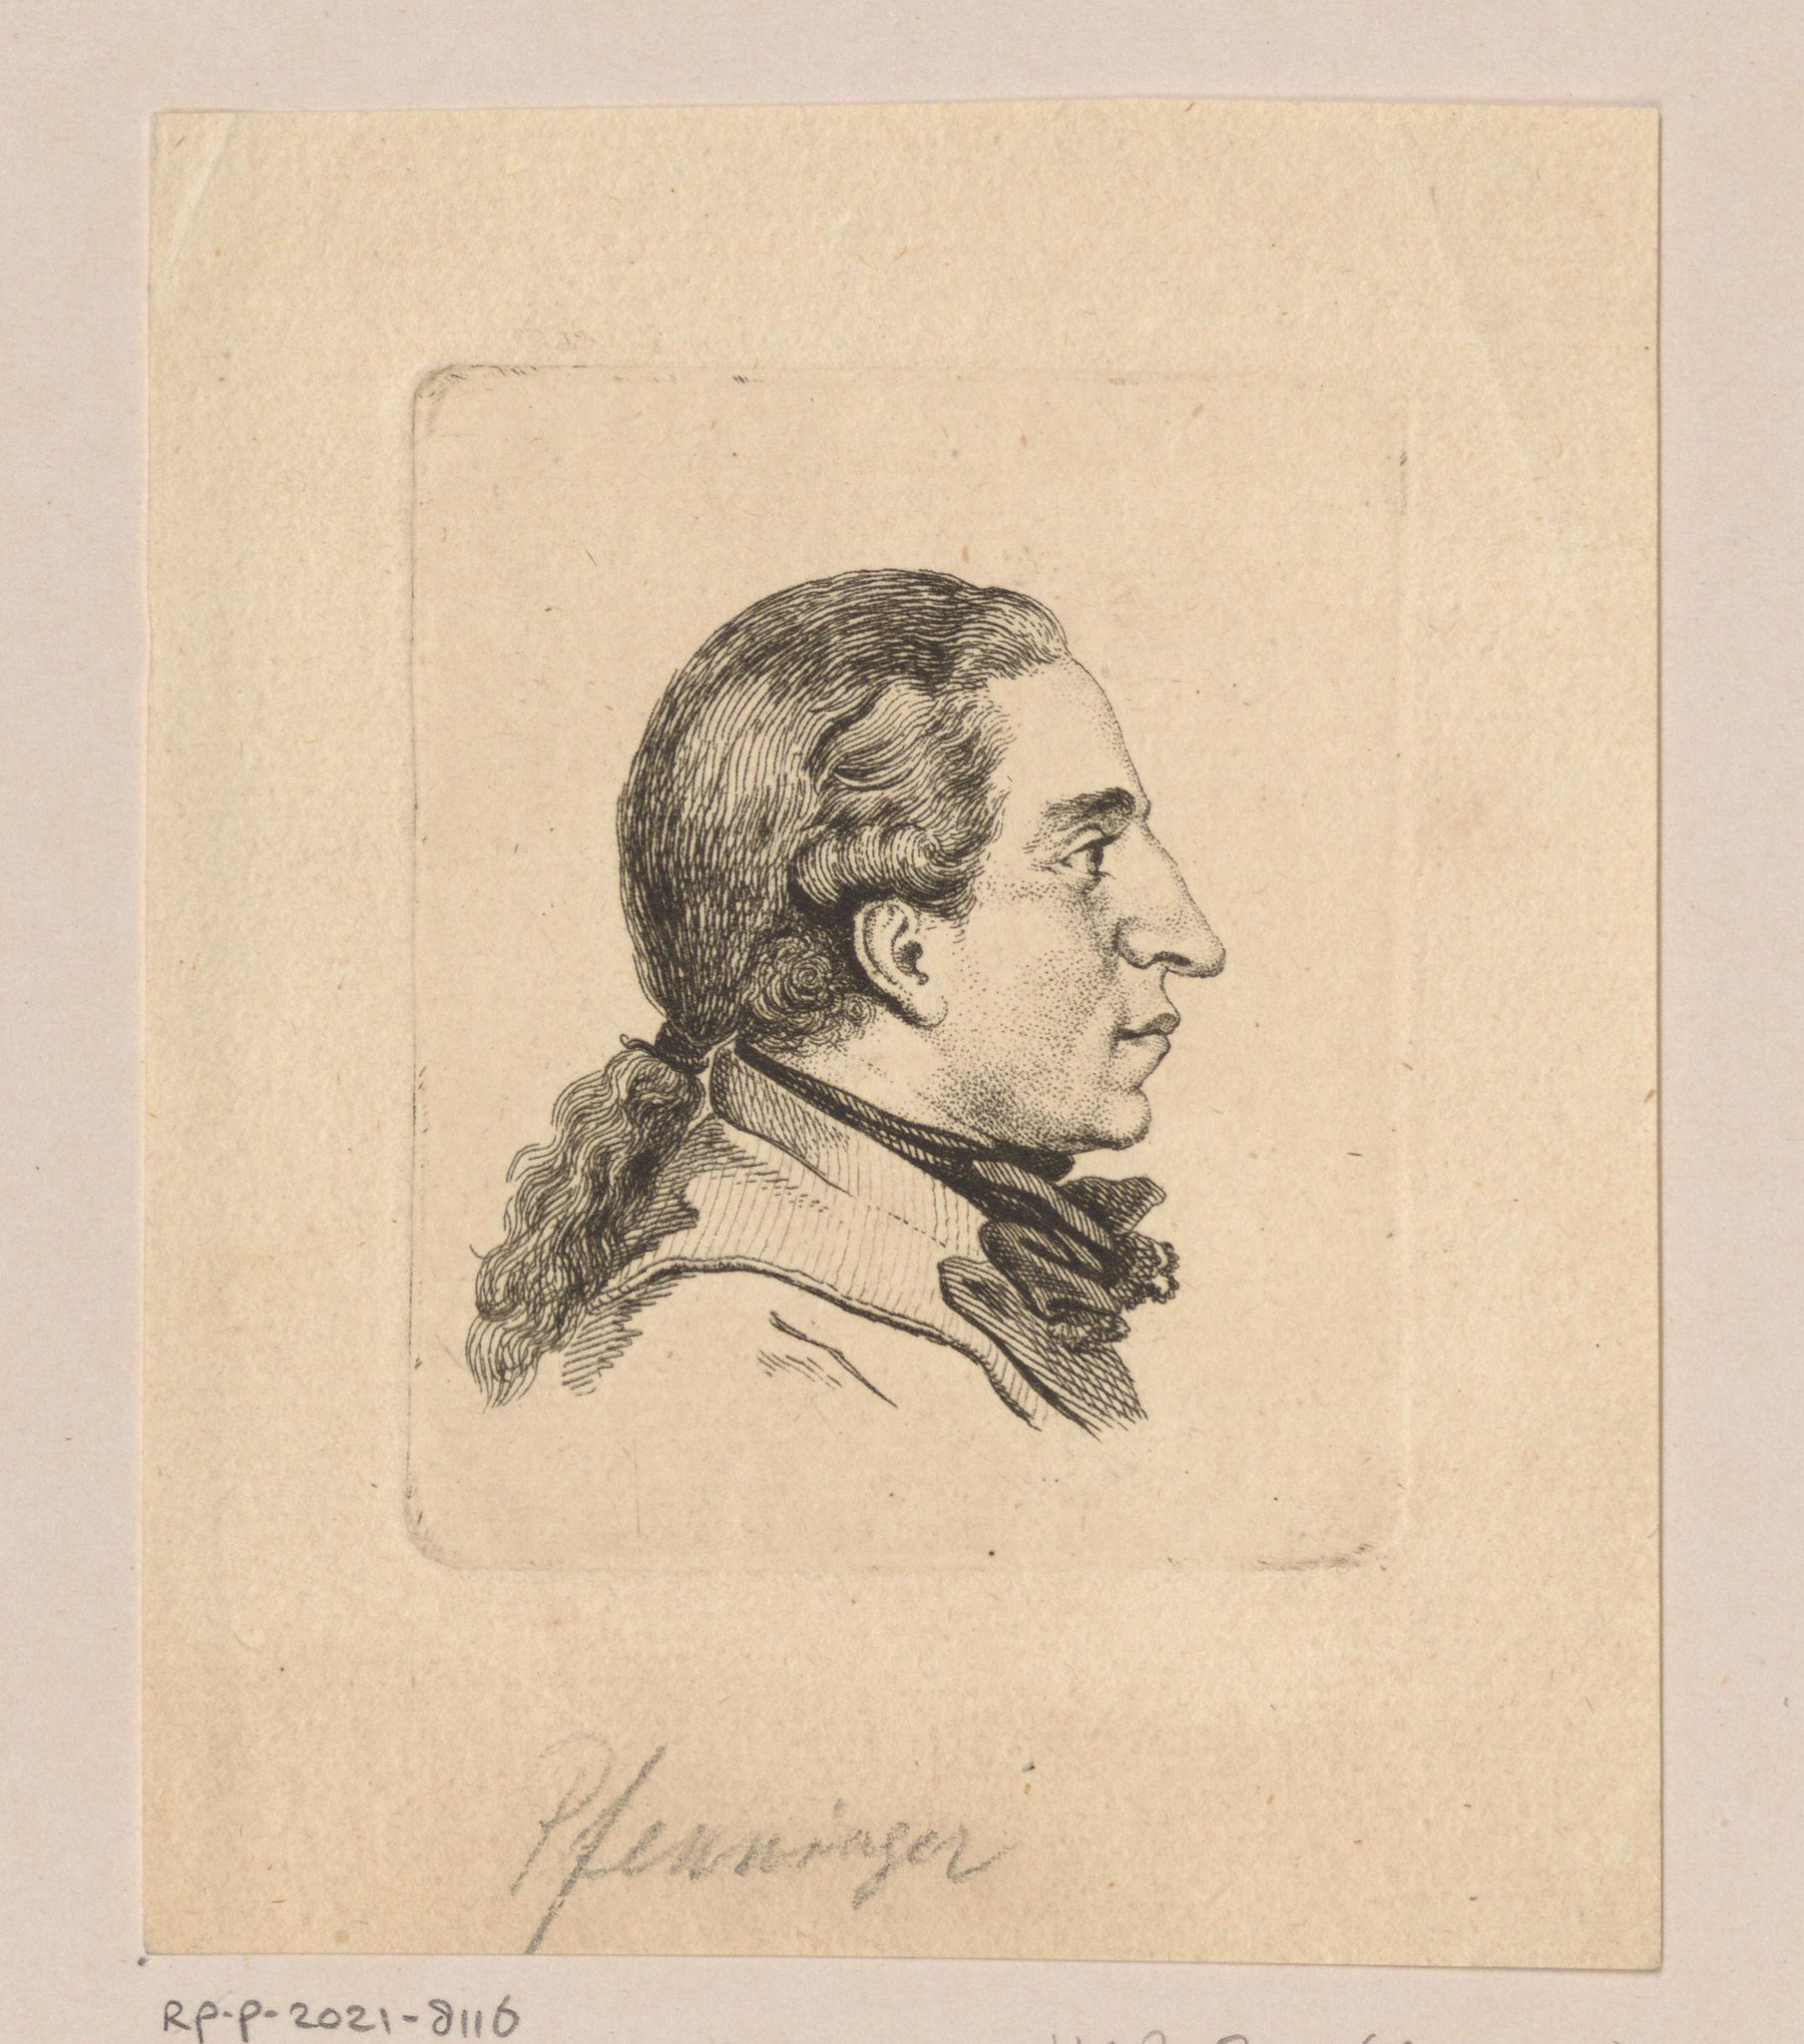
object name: print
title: Portret van Heinrich Pfenninger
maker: Anonymous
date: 1769-1824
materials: paper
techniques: etching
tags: print maker, heinrich pfenninger, adult man, historical persons